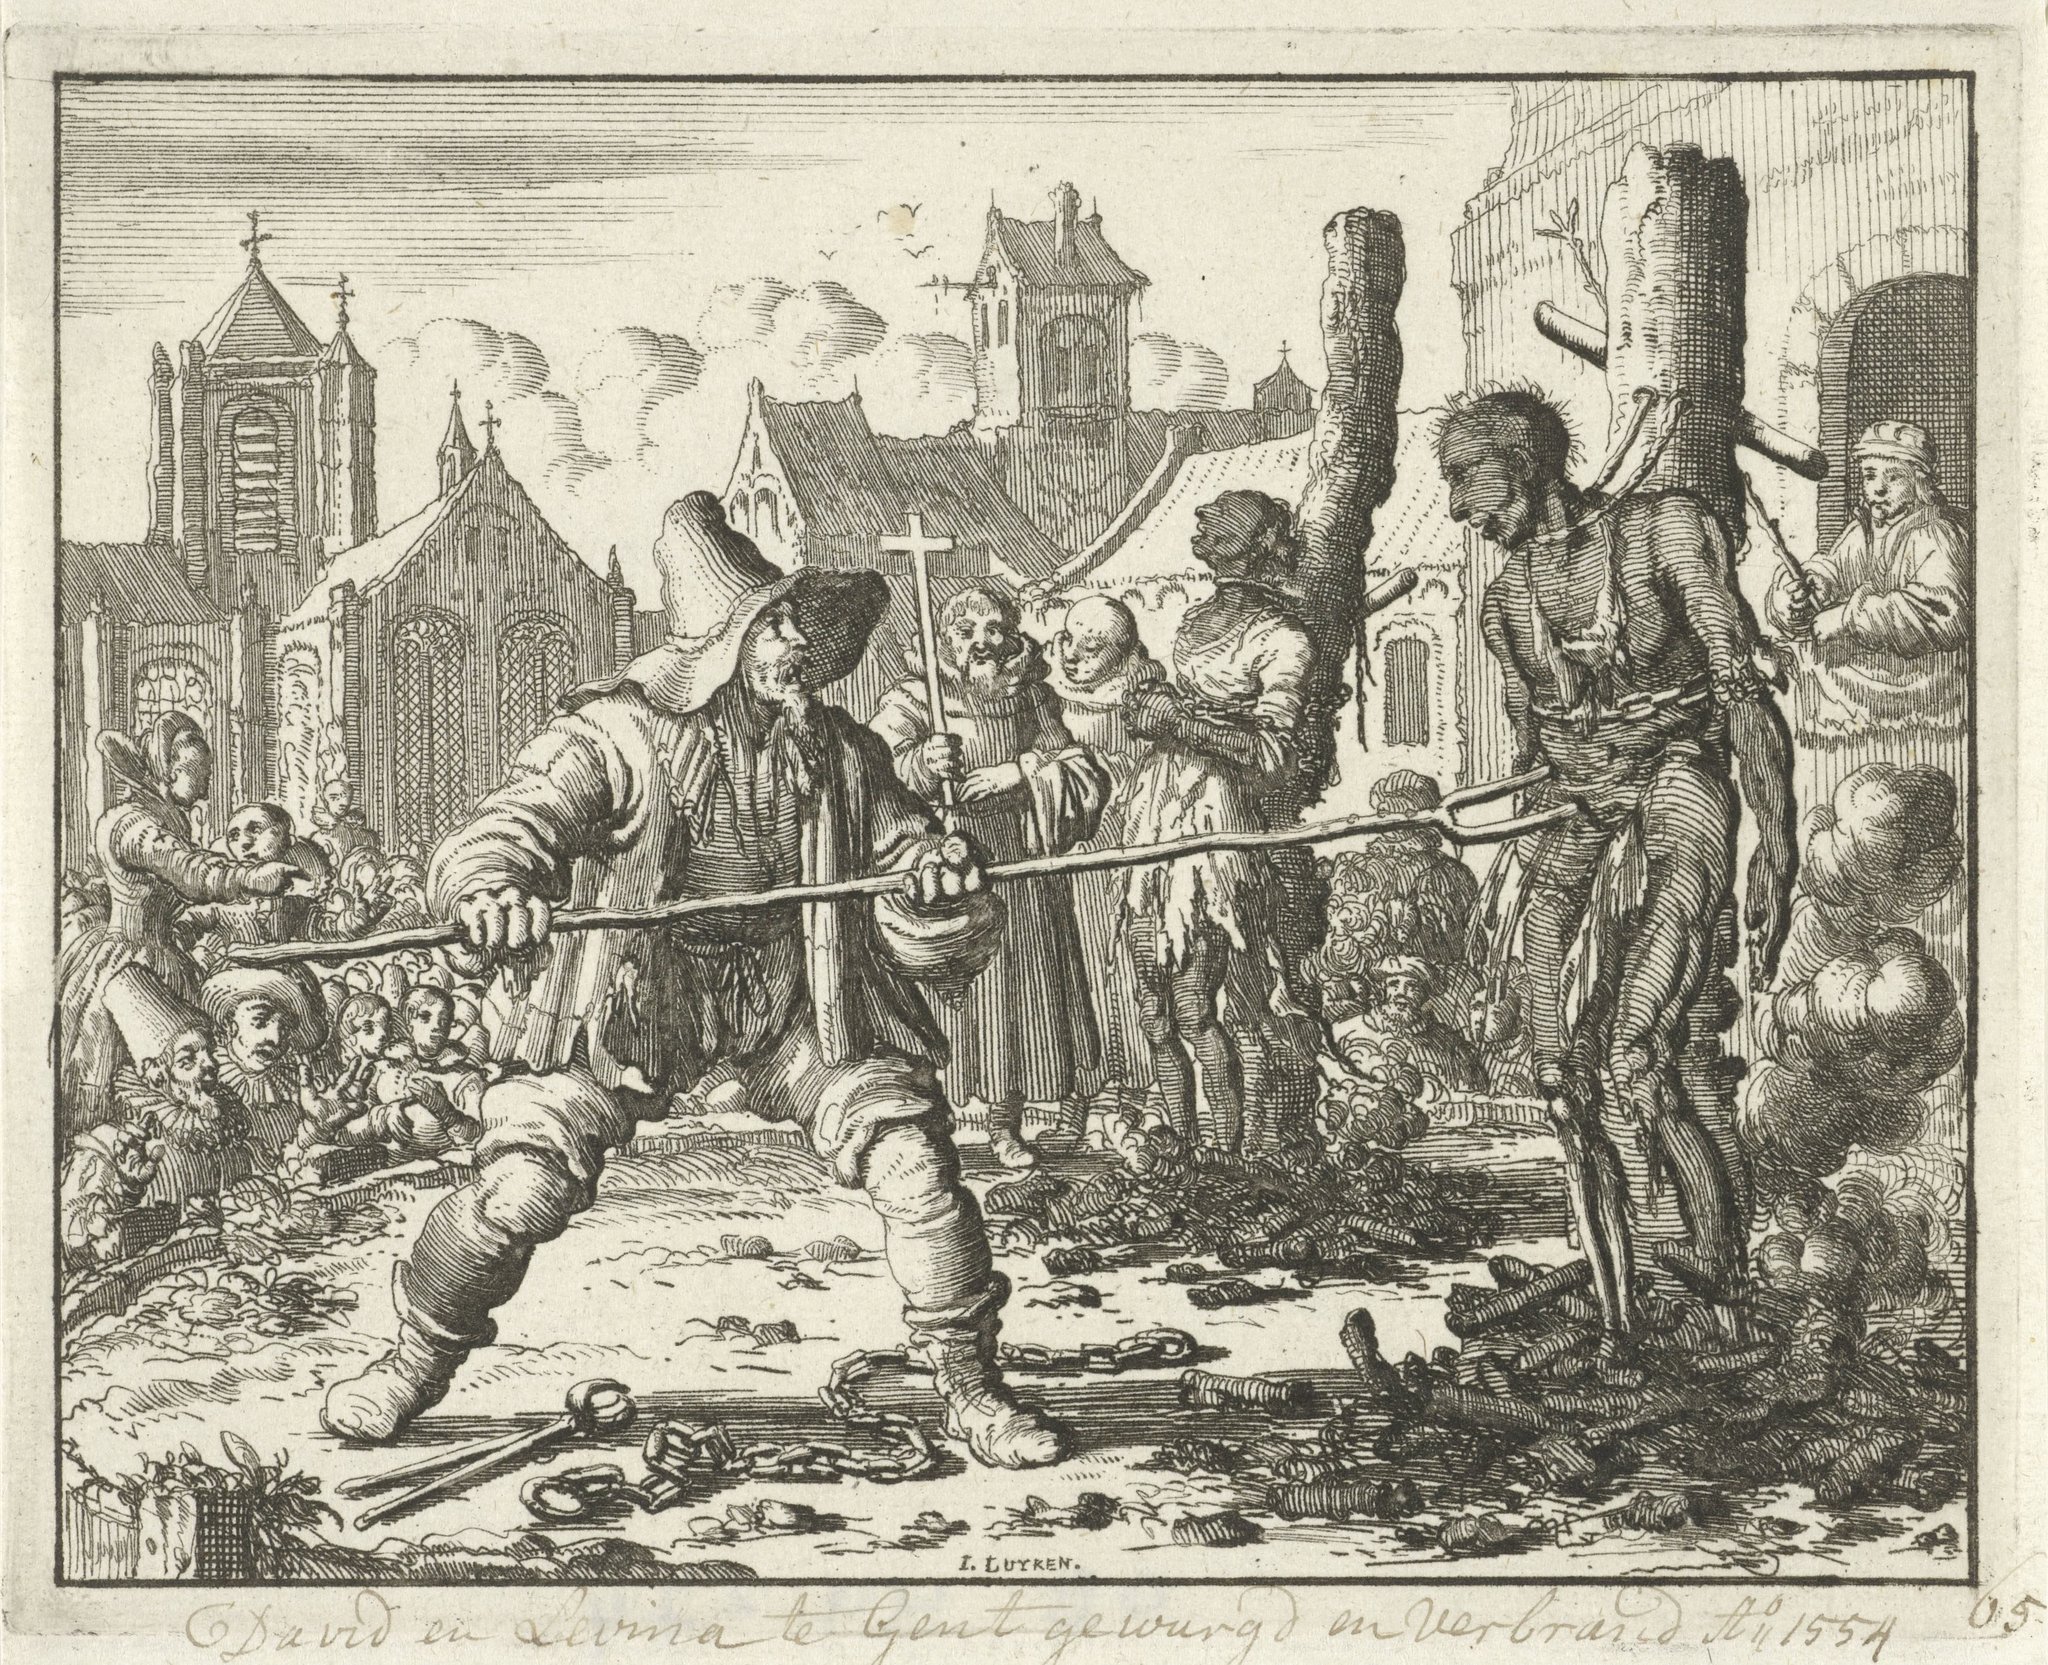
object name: print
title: Verbrande lijken van David en Levina te Gent, 1554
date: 1685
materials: paper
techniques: etching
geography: amsterdam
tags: execution of heretic, e.g. by burning at the stake, 'auto-da-fé', ghent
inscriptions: collector's mark: Lugt 2228, number: ‘65’, inscription: ‘David en [...] Ao 1554’